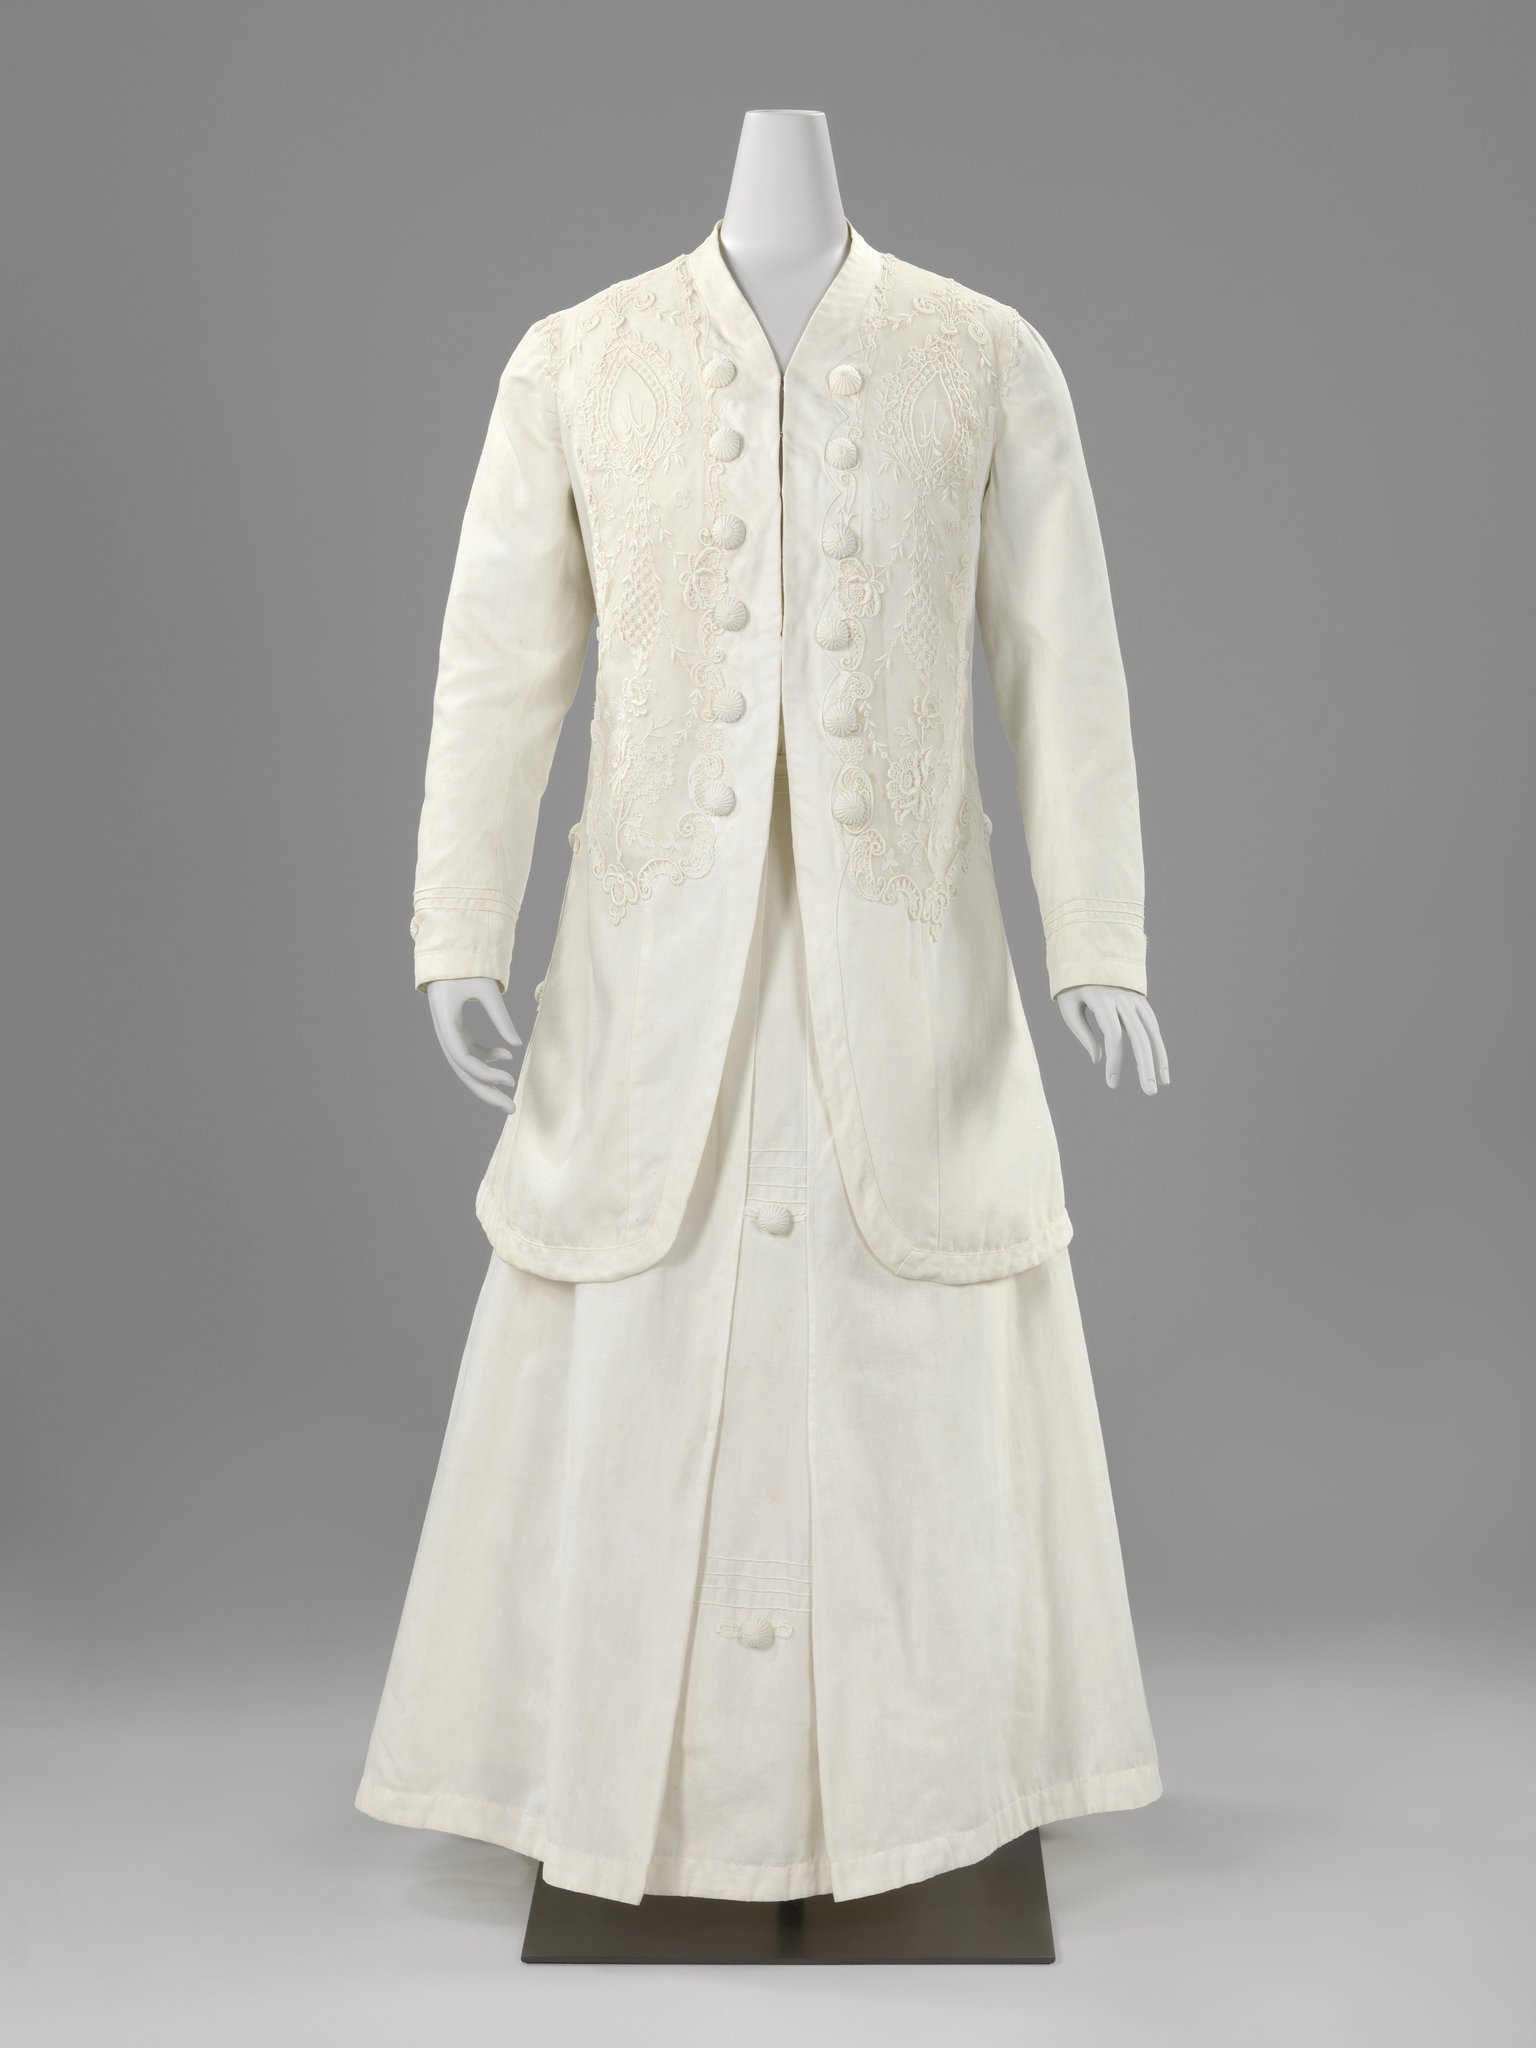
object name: skirt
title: Rok van mantelpak van witte keperkatoen versierd met een oprijg- en knoopversiering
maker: Anonymous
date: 1907-1909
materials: cotton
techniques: weave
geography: netherlands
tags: utrecht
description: Rok van mantelpak van witte keperkatoen versierd met een oprijg- en knoopversiering. Model: lang, gerend, iets slepend, met vier stolpplooien, waarin aan de voorkant drie ingezette banen met oprijg- en knoopversiering. De knopen zijn van witte, geborduurde en opgevulde stof.